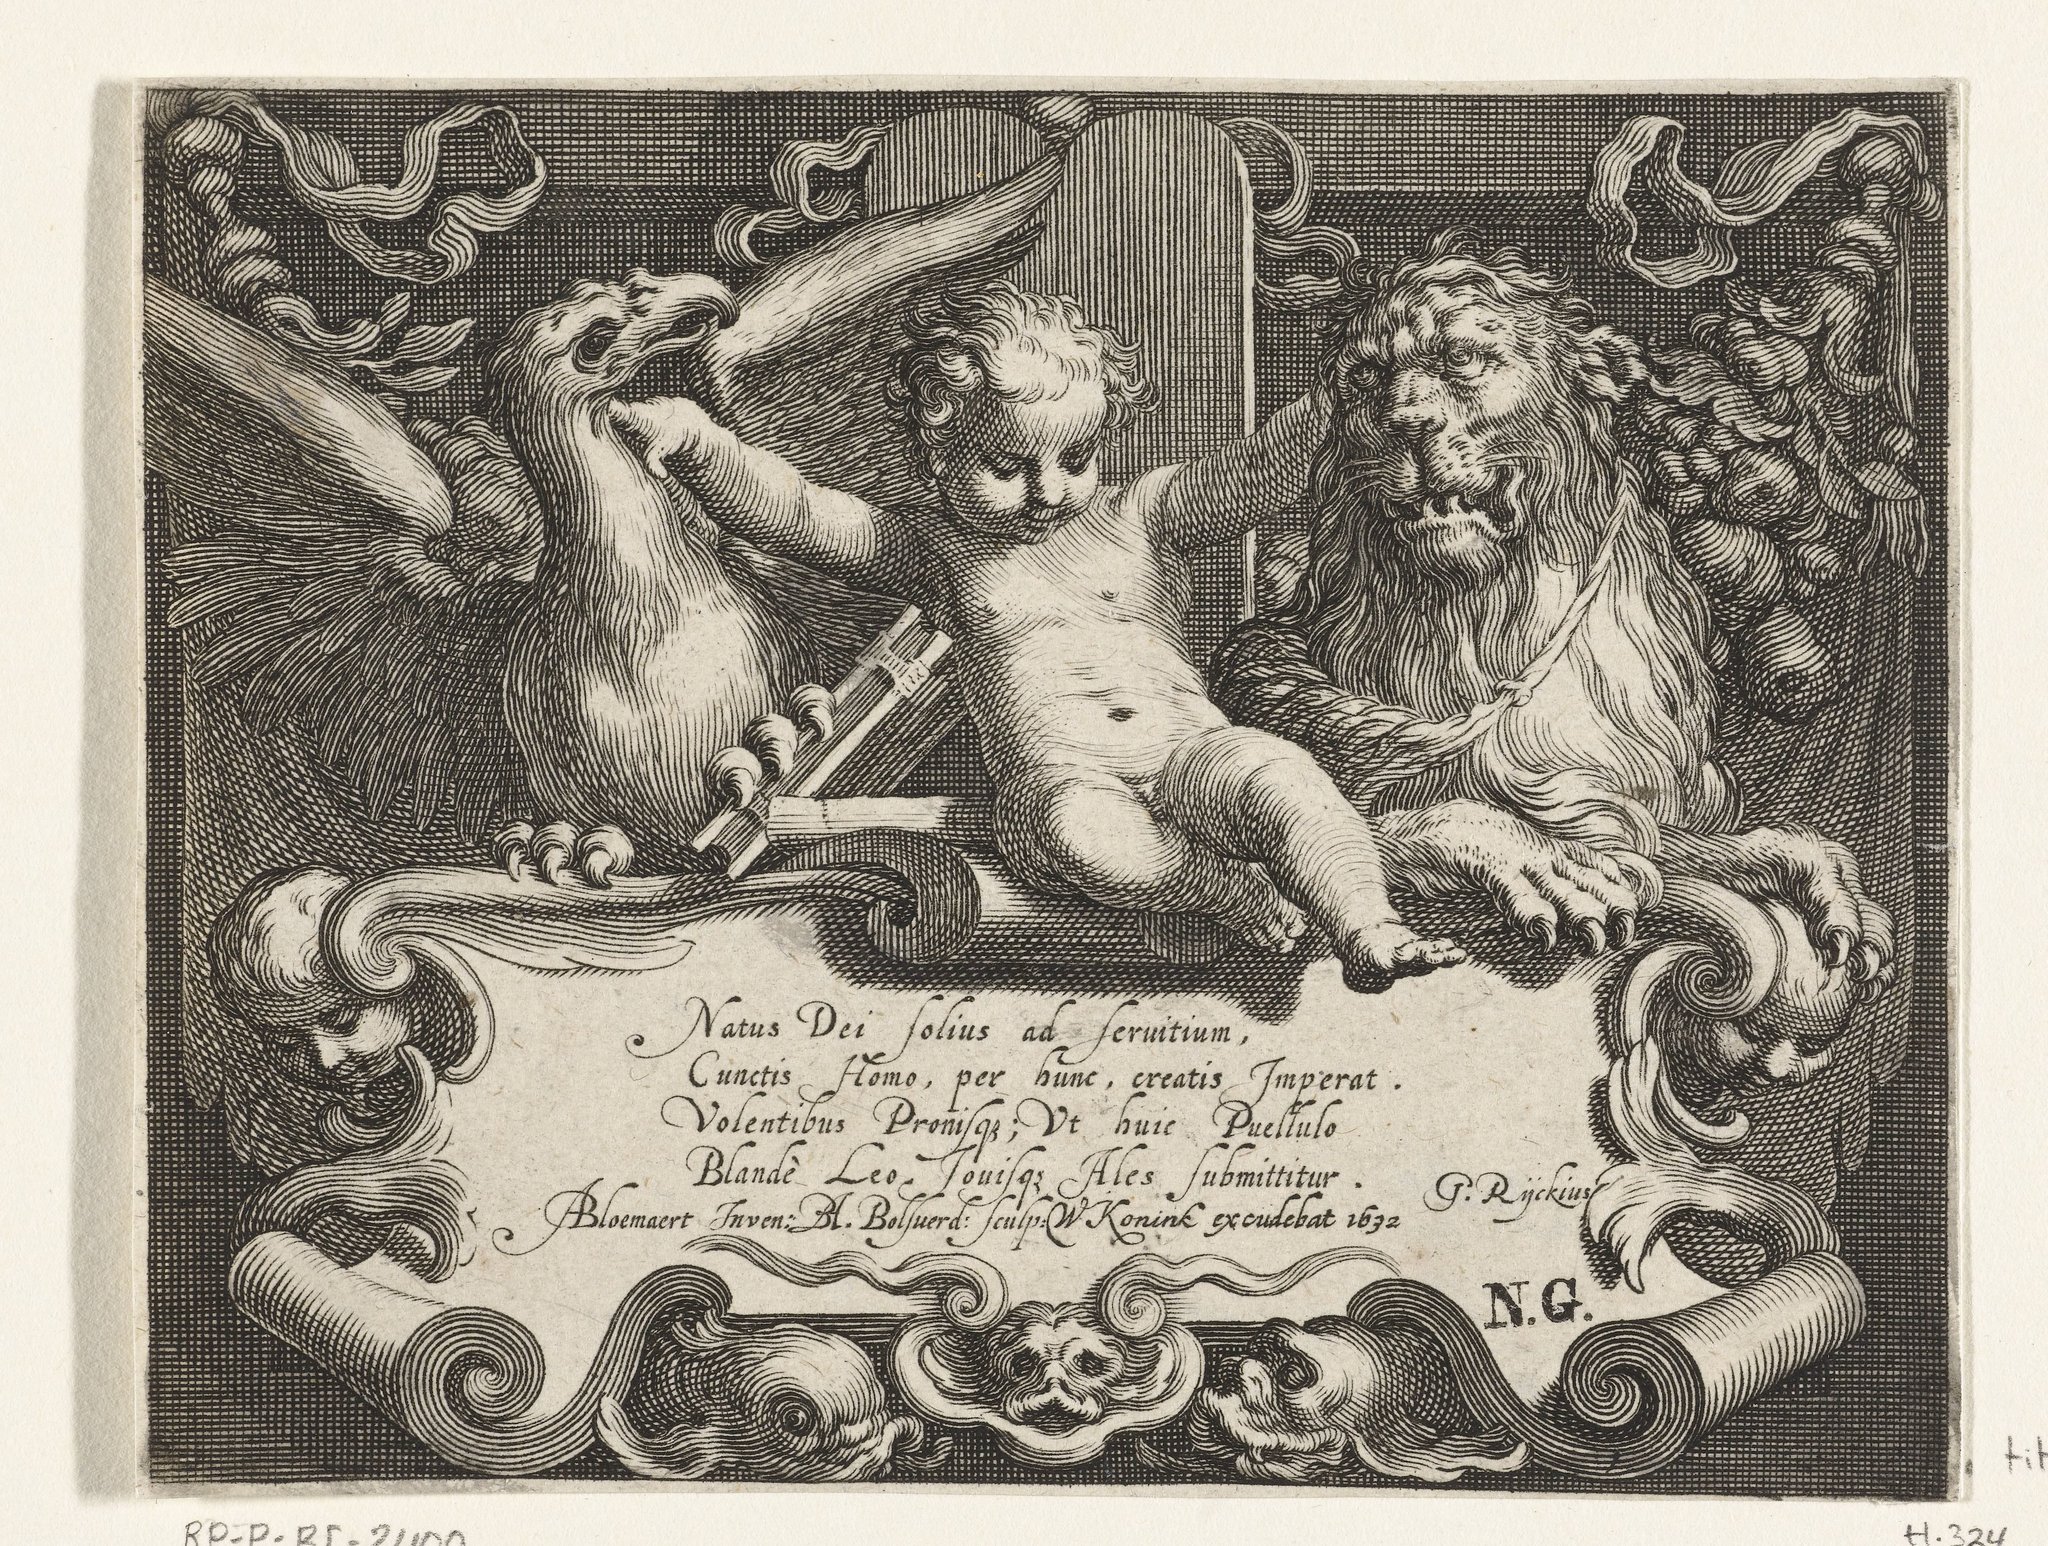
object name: titelprent, frontispice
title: Pastoralen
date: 1632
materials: paper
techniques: engraving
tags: dolphin ~ ornament, predatory birds: eagle, beasts of prey, predatory animals: lion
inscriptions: collector's mark: Lugt 1967, collector's mark: Lugt 2228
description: Een kind bedaart of temt een leeuw en roofvogel. Zij zitten bovenop een schild met een vers in Latijn. Het schild is rijk geornamenteerd met krulwerk, twee cherubijnen en dolfijnen. Volgens het vers toont dit kind door het temmen van de dieren dat de mens door God de leiding over het dierenrijk heeft.